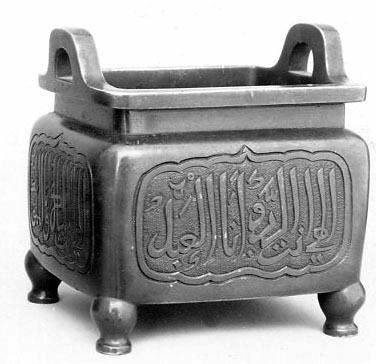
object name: incense burner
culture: chinese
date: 1506-1521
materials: bronze